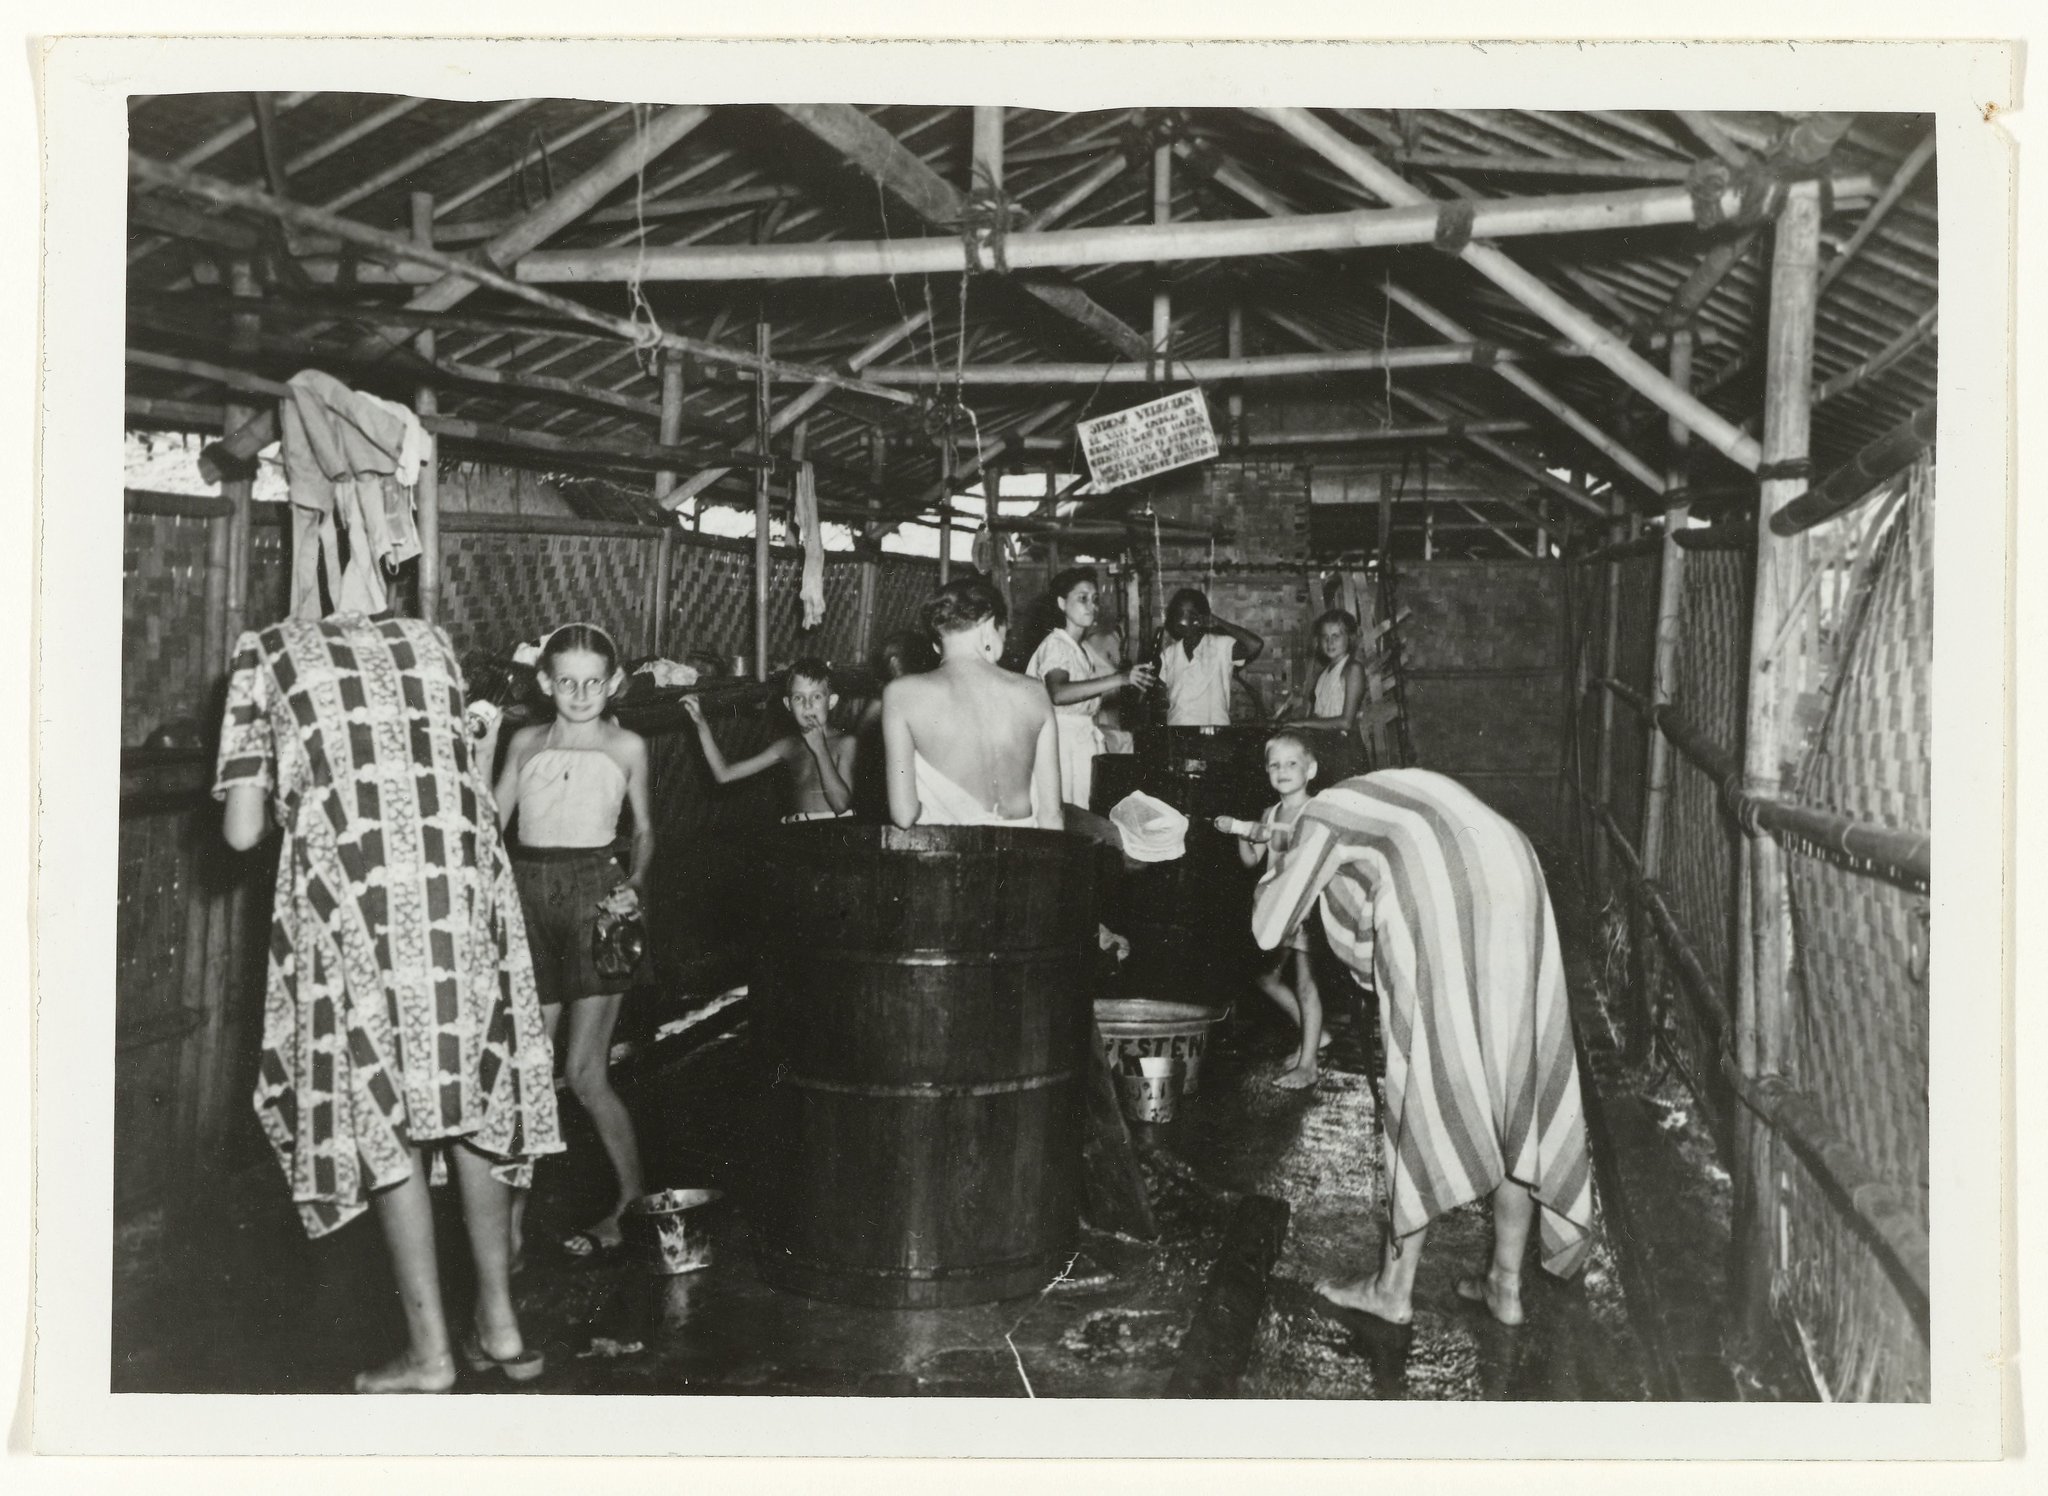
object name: photograph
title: Wasplaats van het interneringskamp te Makassar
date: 1945-1946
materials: photographic support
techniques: photography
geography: indonesia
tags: indonesia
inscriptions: inscription, stamp: ‘COPYRIGHT / 'ANEFO' / ALGEMEEN NEDERLANDSCH FOTOBUREAU’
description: De wasplaats van het interneringskamp te Makassar in Nederlands-Indië na de bevrijding. In dit kamp zaten 10.000 vrouwen en meisjes tijdens de Japanse bezetting.